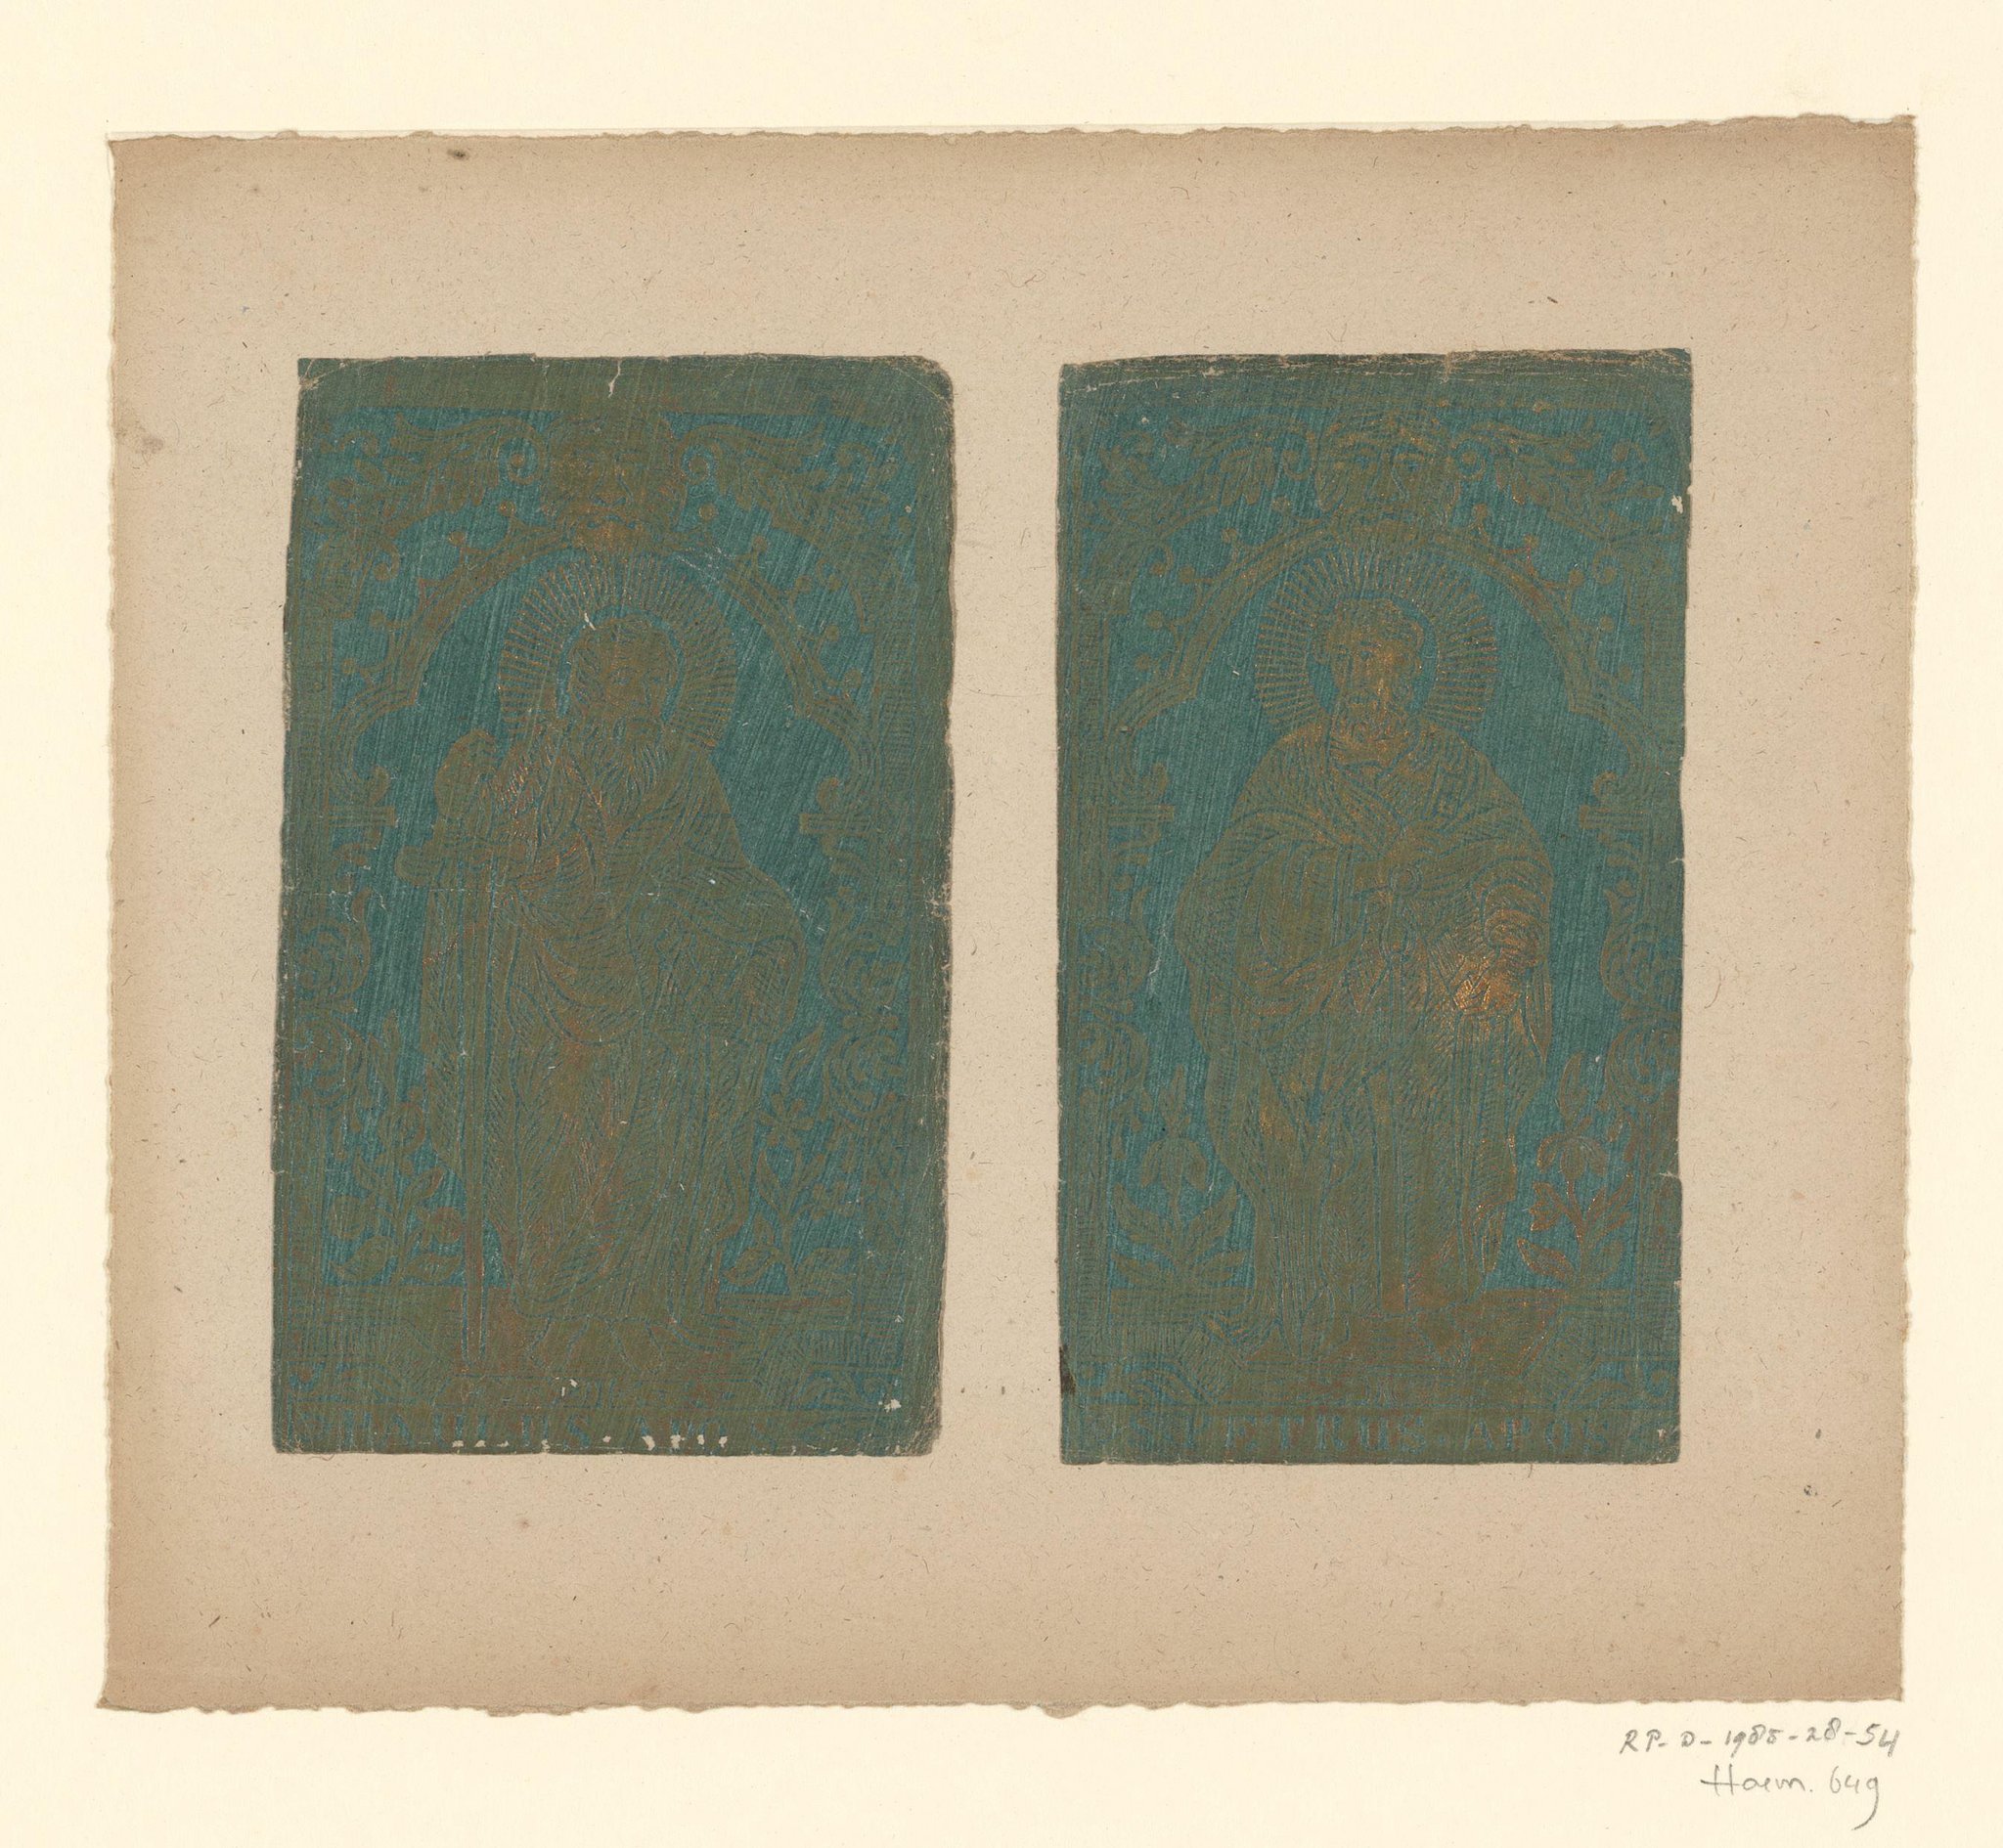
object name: brocade paper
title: Heiligen Paulus en Petrus staande in een boog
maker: Anonymous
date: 1700-1850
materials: gold leaf, paper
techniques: relief print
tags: the apostle peter, first bishop of rome; possible attributes: book, cock, (upturned) cross, (triple) crozier, fish, key, scroll, ship, tiara, the apostle paul of tarsus; possible attributes: book, scroll, sword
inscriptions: collector's mark: Lugt 2228, collector's mark: Lugt 2760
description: Heiligen Paulus en Petrus staande in een met ornamenten en bloemen versierde boog met aan de bovenkant een leeuwenkop. Twee uitgeknipte en opgeplakte fragmenten.